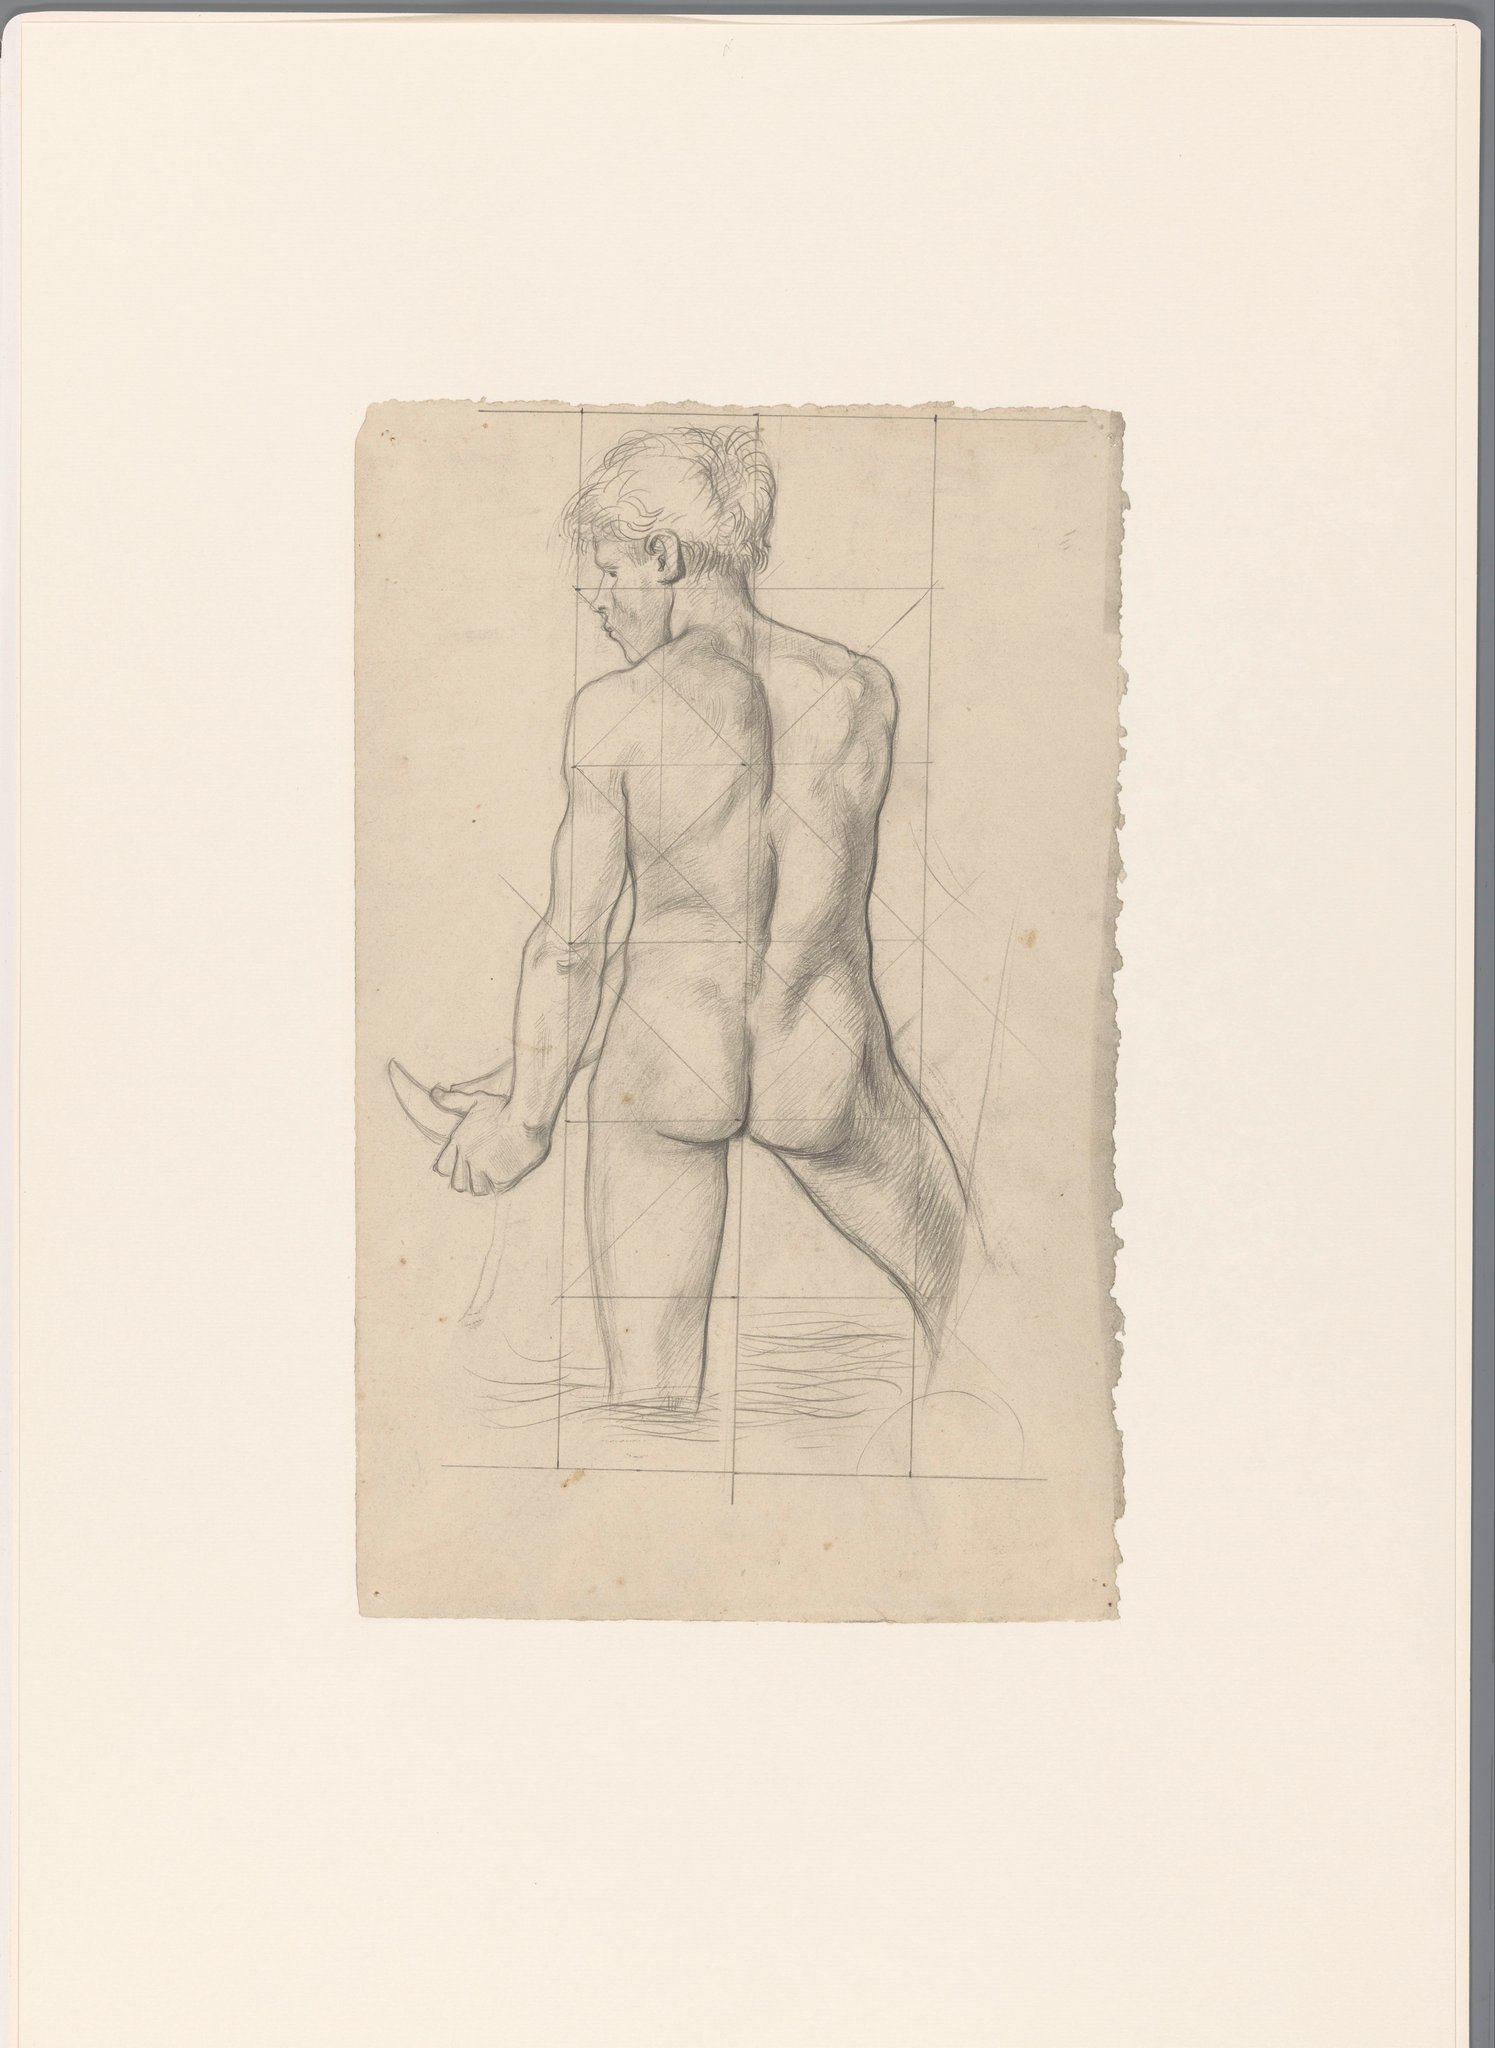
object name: drawing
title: Staand mannelijk naakt in het water, op de rug gezien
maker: richard nicolaüs roland holst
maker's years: 1868-1938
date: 1878-1938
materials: paper, pencil